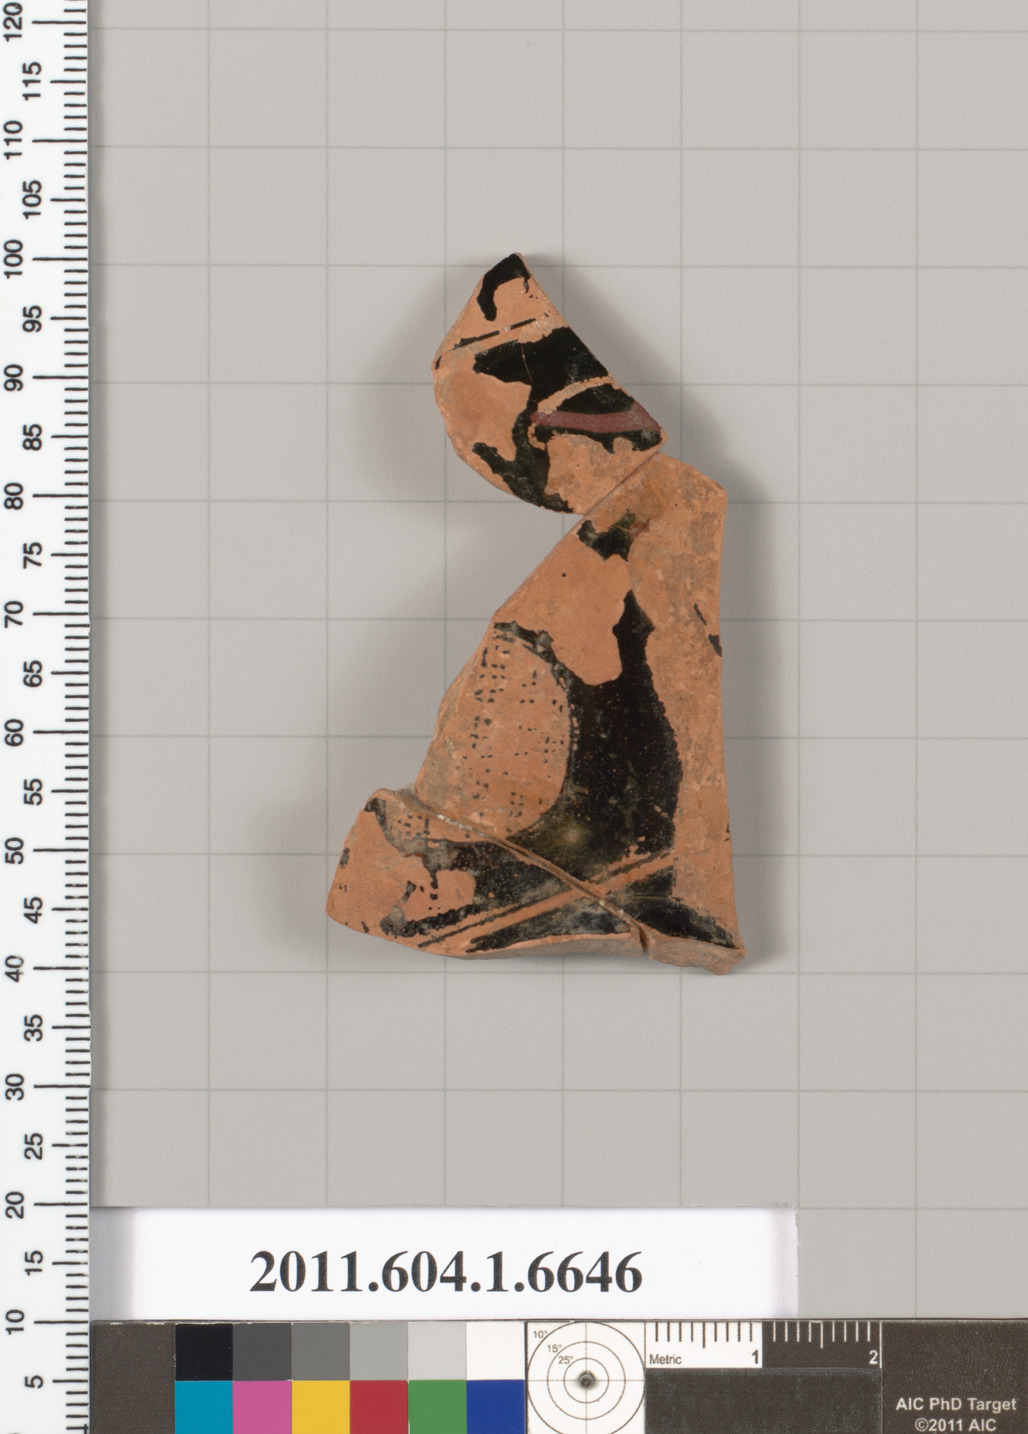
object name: kylix fragment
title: Terracotta fragment of a kylix (drinking cup)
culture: greek, attic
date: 490-470 BCE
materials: terracotta